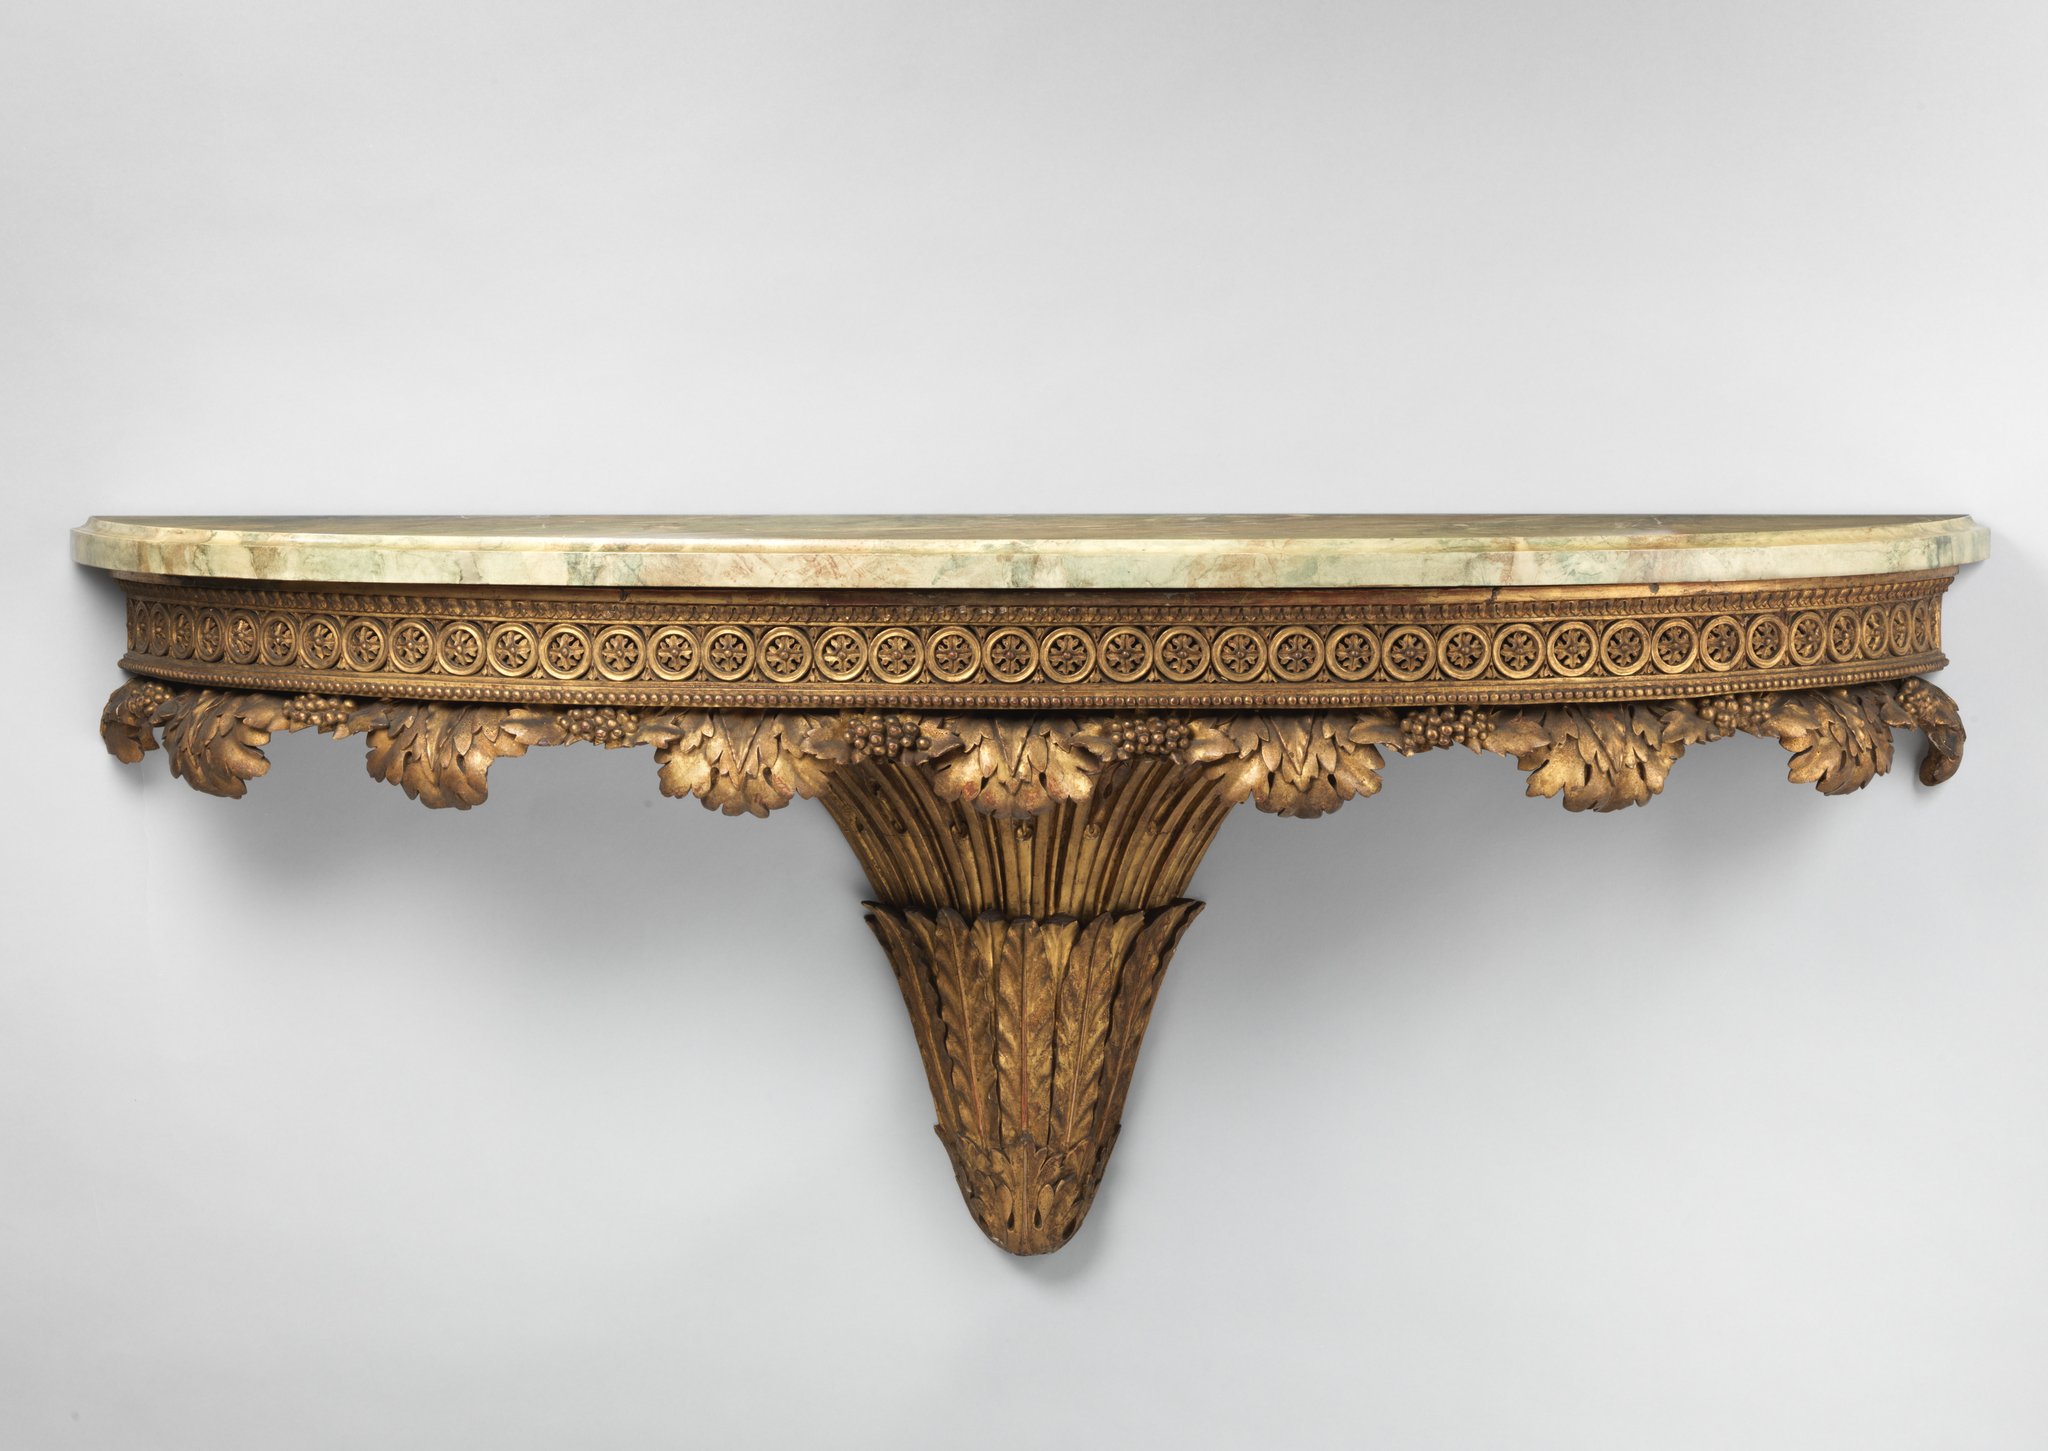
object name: console table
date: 1701-1800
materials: wood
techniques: carving, gilding